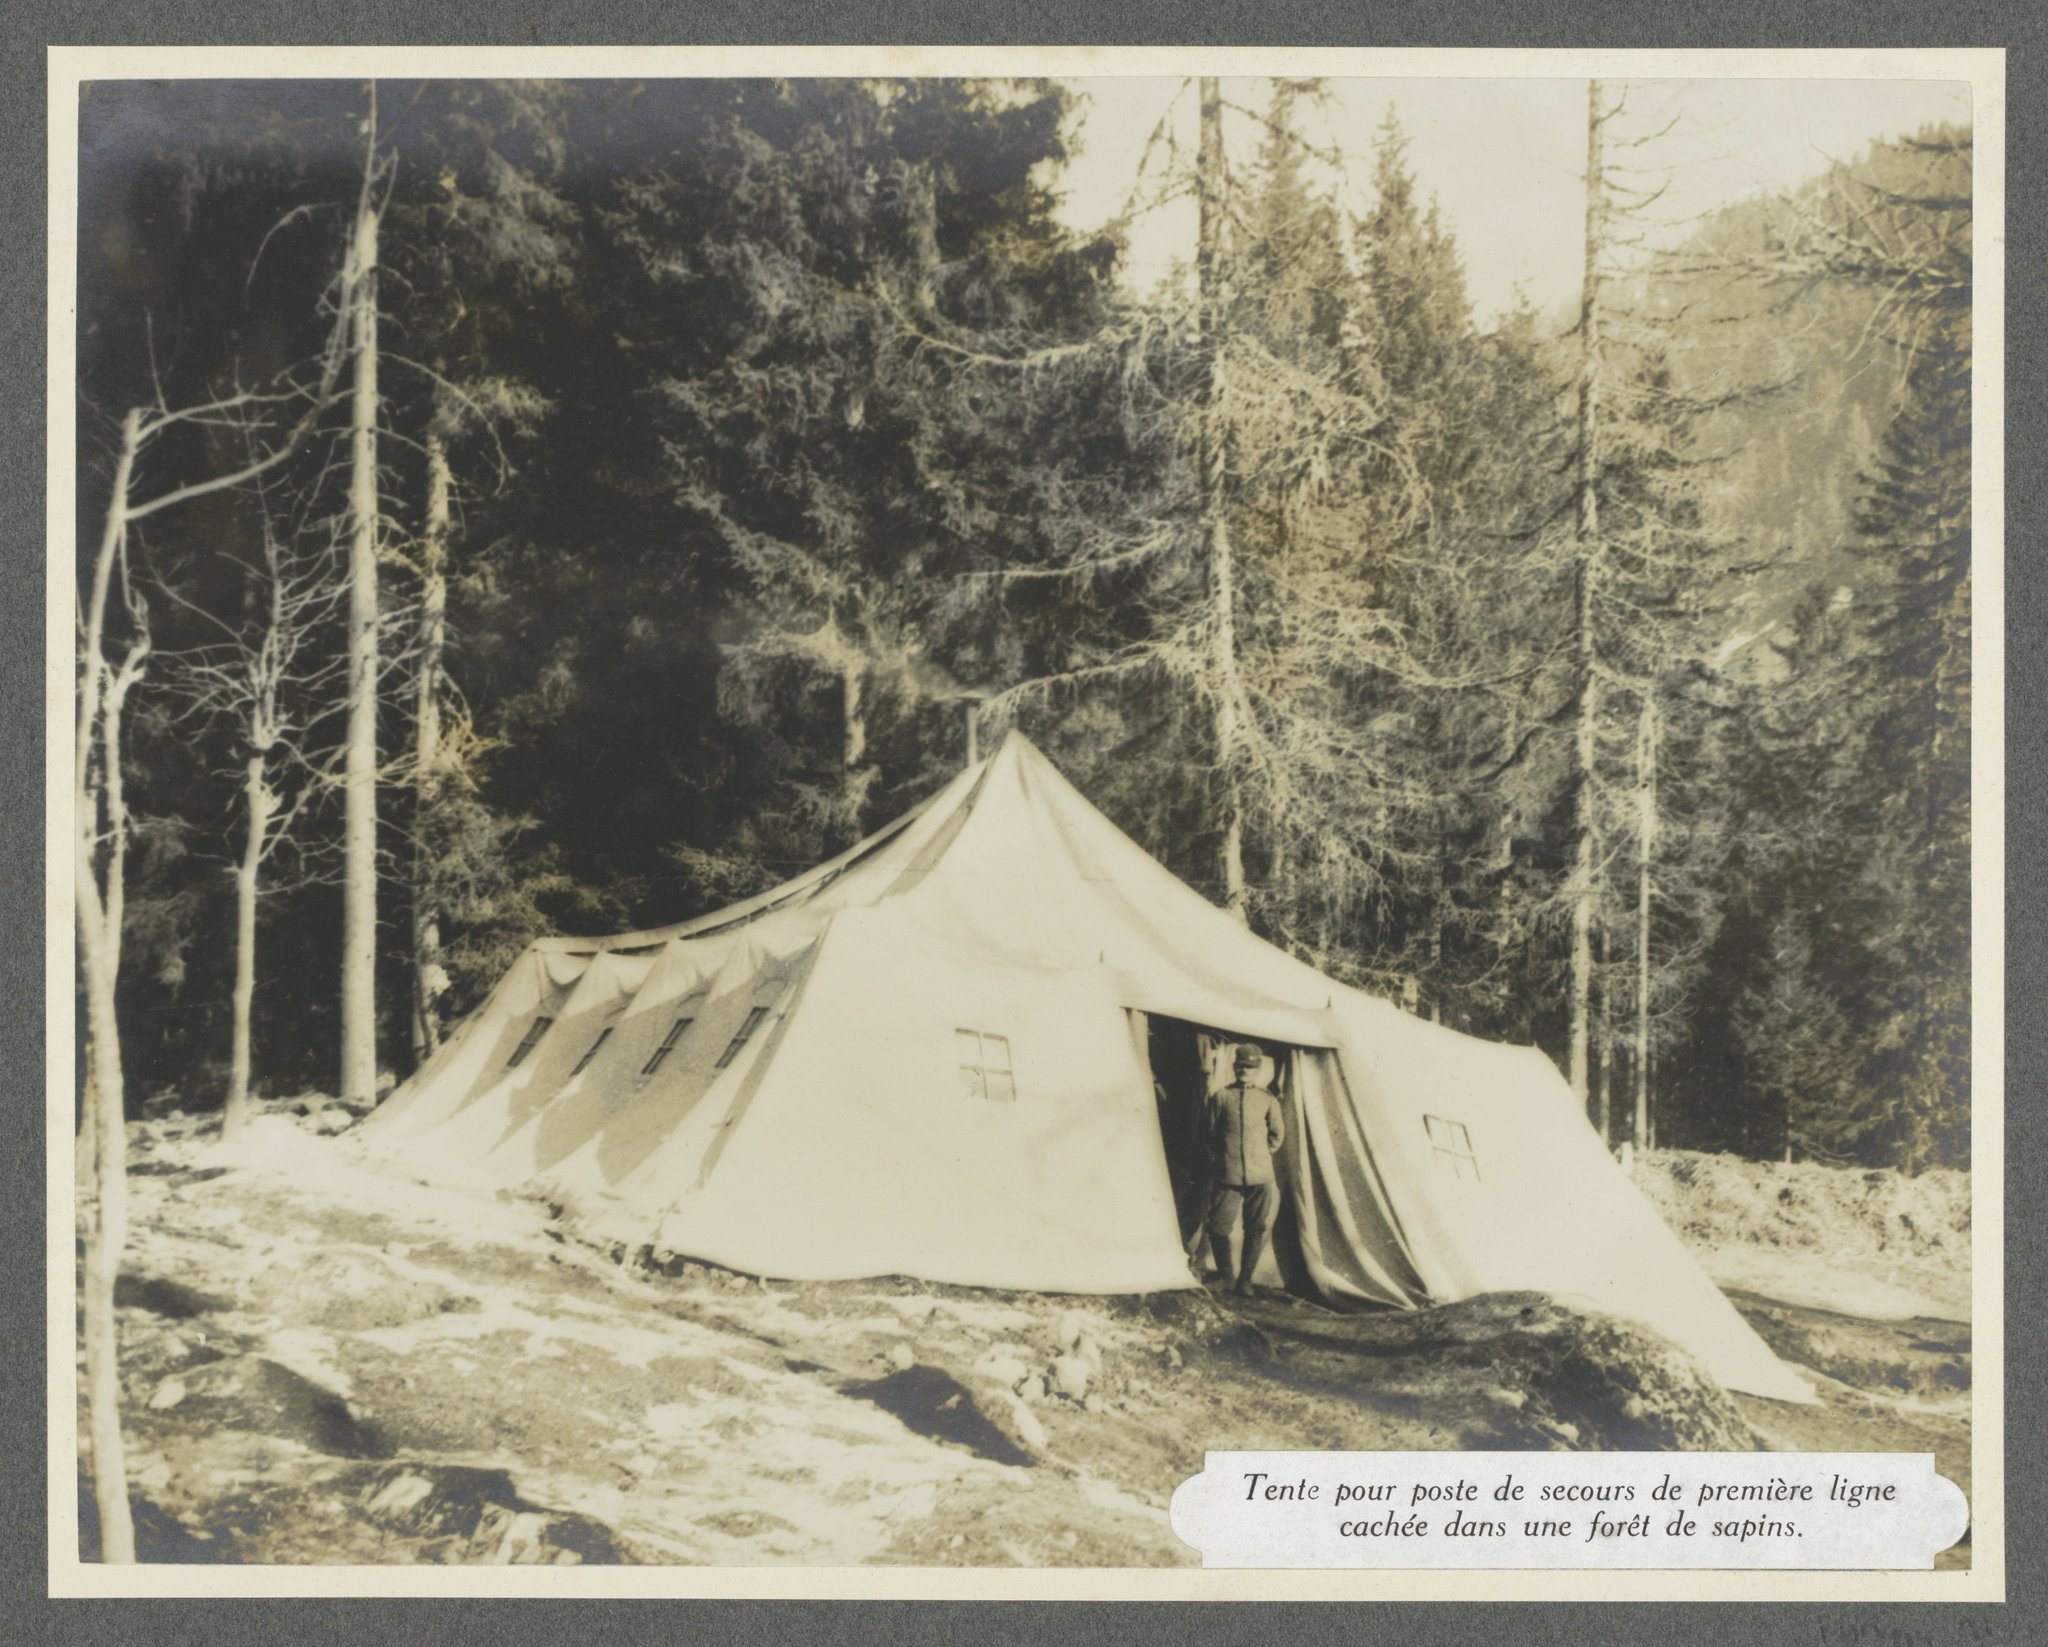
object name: photograph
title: Vermoedelijk Italiaanse militair poserend voor een tent van de hulpdienst, verborgen in een dennenbos in de Dolomieten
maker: henri de rothschild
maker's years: 1872-1947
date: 1916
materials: photographic support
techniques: gelatin silver print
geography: dolomites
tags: war (+ land forces), (military) camp with tents (+ warfare in mountainous area)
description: Onderdeel van Fotoalbum Medische missie H. de Rothschild naar het Italiaanse front 1916.